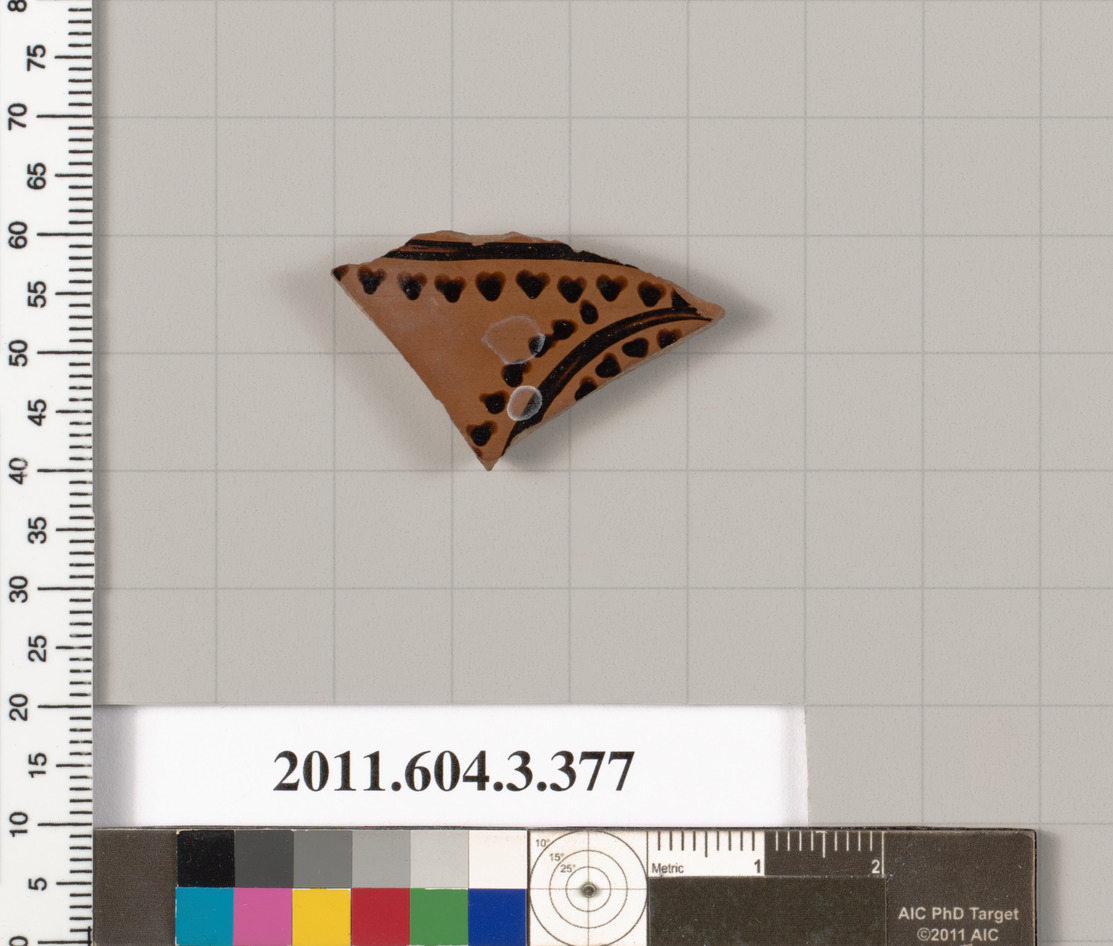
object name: neck amphora fragment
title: Terracotta fragment of a neck-amphora (jar)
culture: greek, attic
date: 530-510 BCE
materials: terracotta